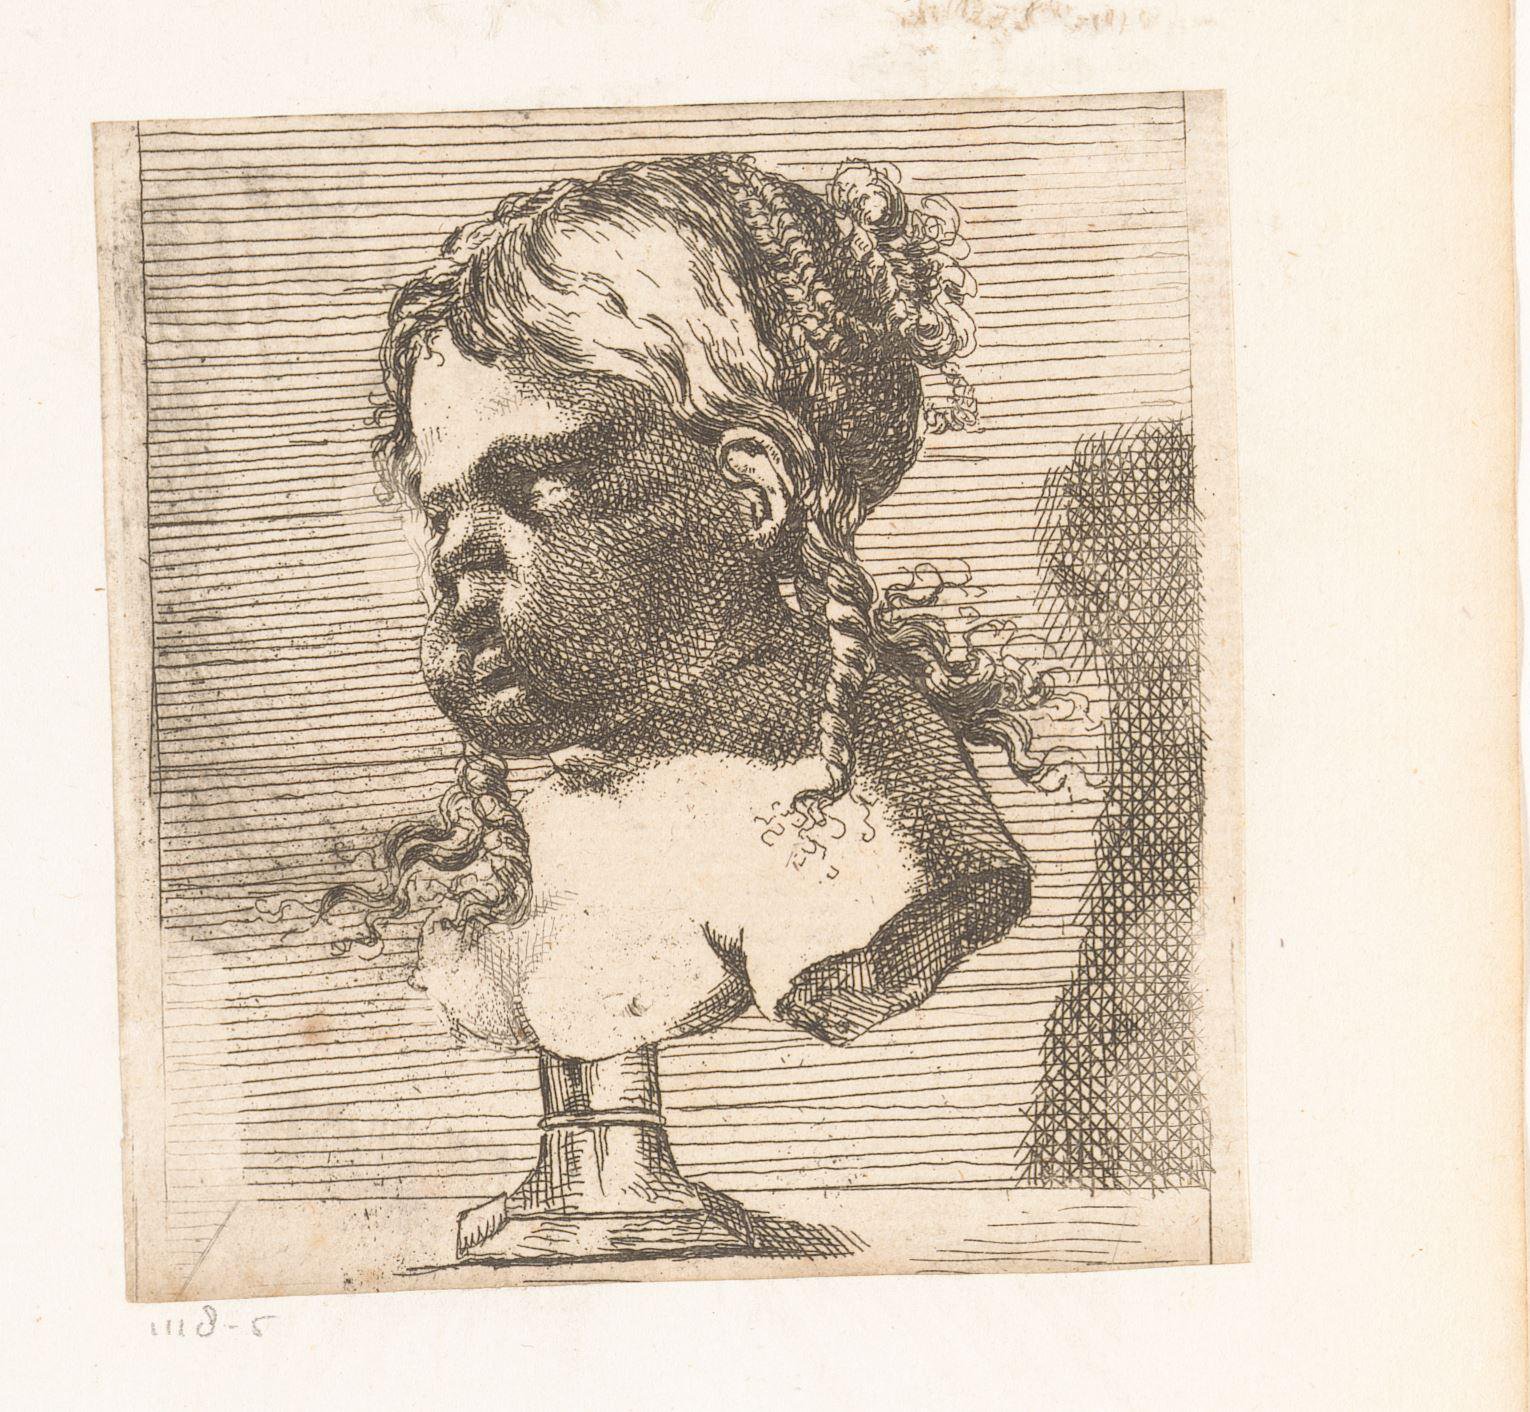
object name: print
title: Herm met gezicht van meisje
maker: françois bourlier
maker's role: draughtsman, painter, print maker, publisher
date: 1660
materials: paper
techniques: etching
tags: herms (garden ornaments), ornament ~ human parts, child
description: Herm met het hoofd van een jong meisje. Onderdeel van een groep van negen bladen van zes verschillende kopjes.